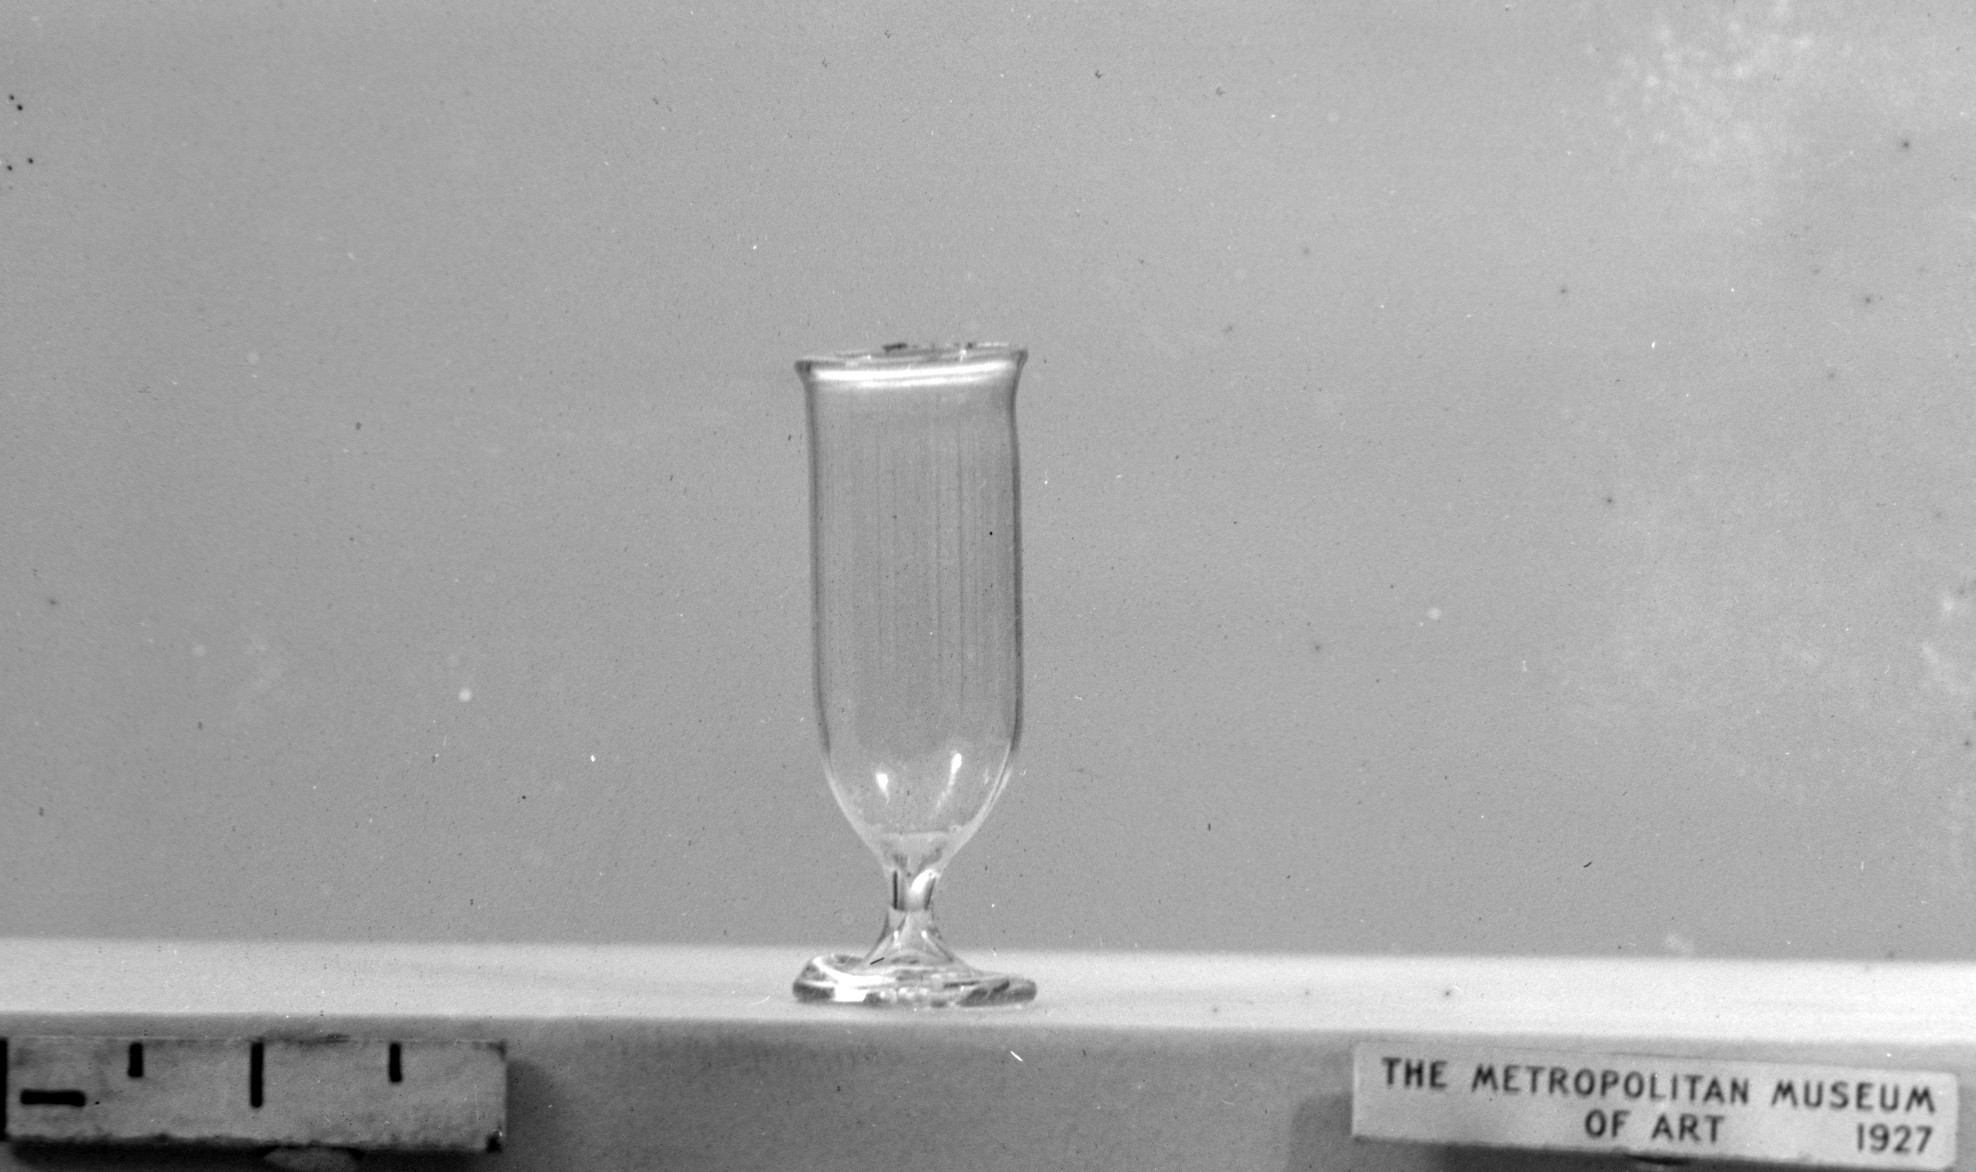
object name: beaker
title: Miniature beaker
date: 1801-1833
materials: glass